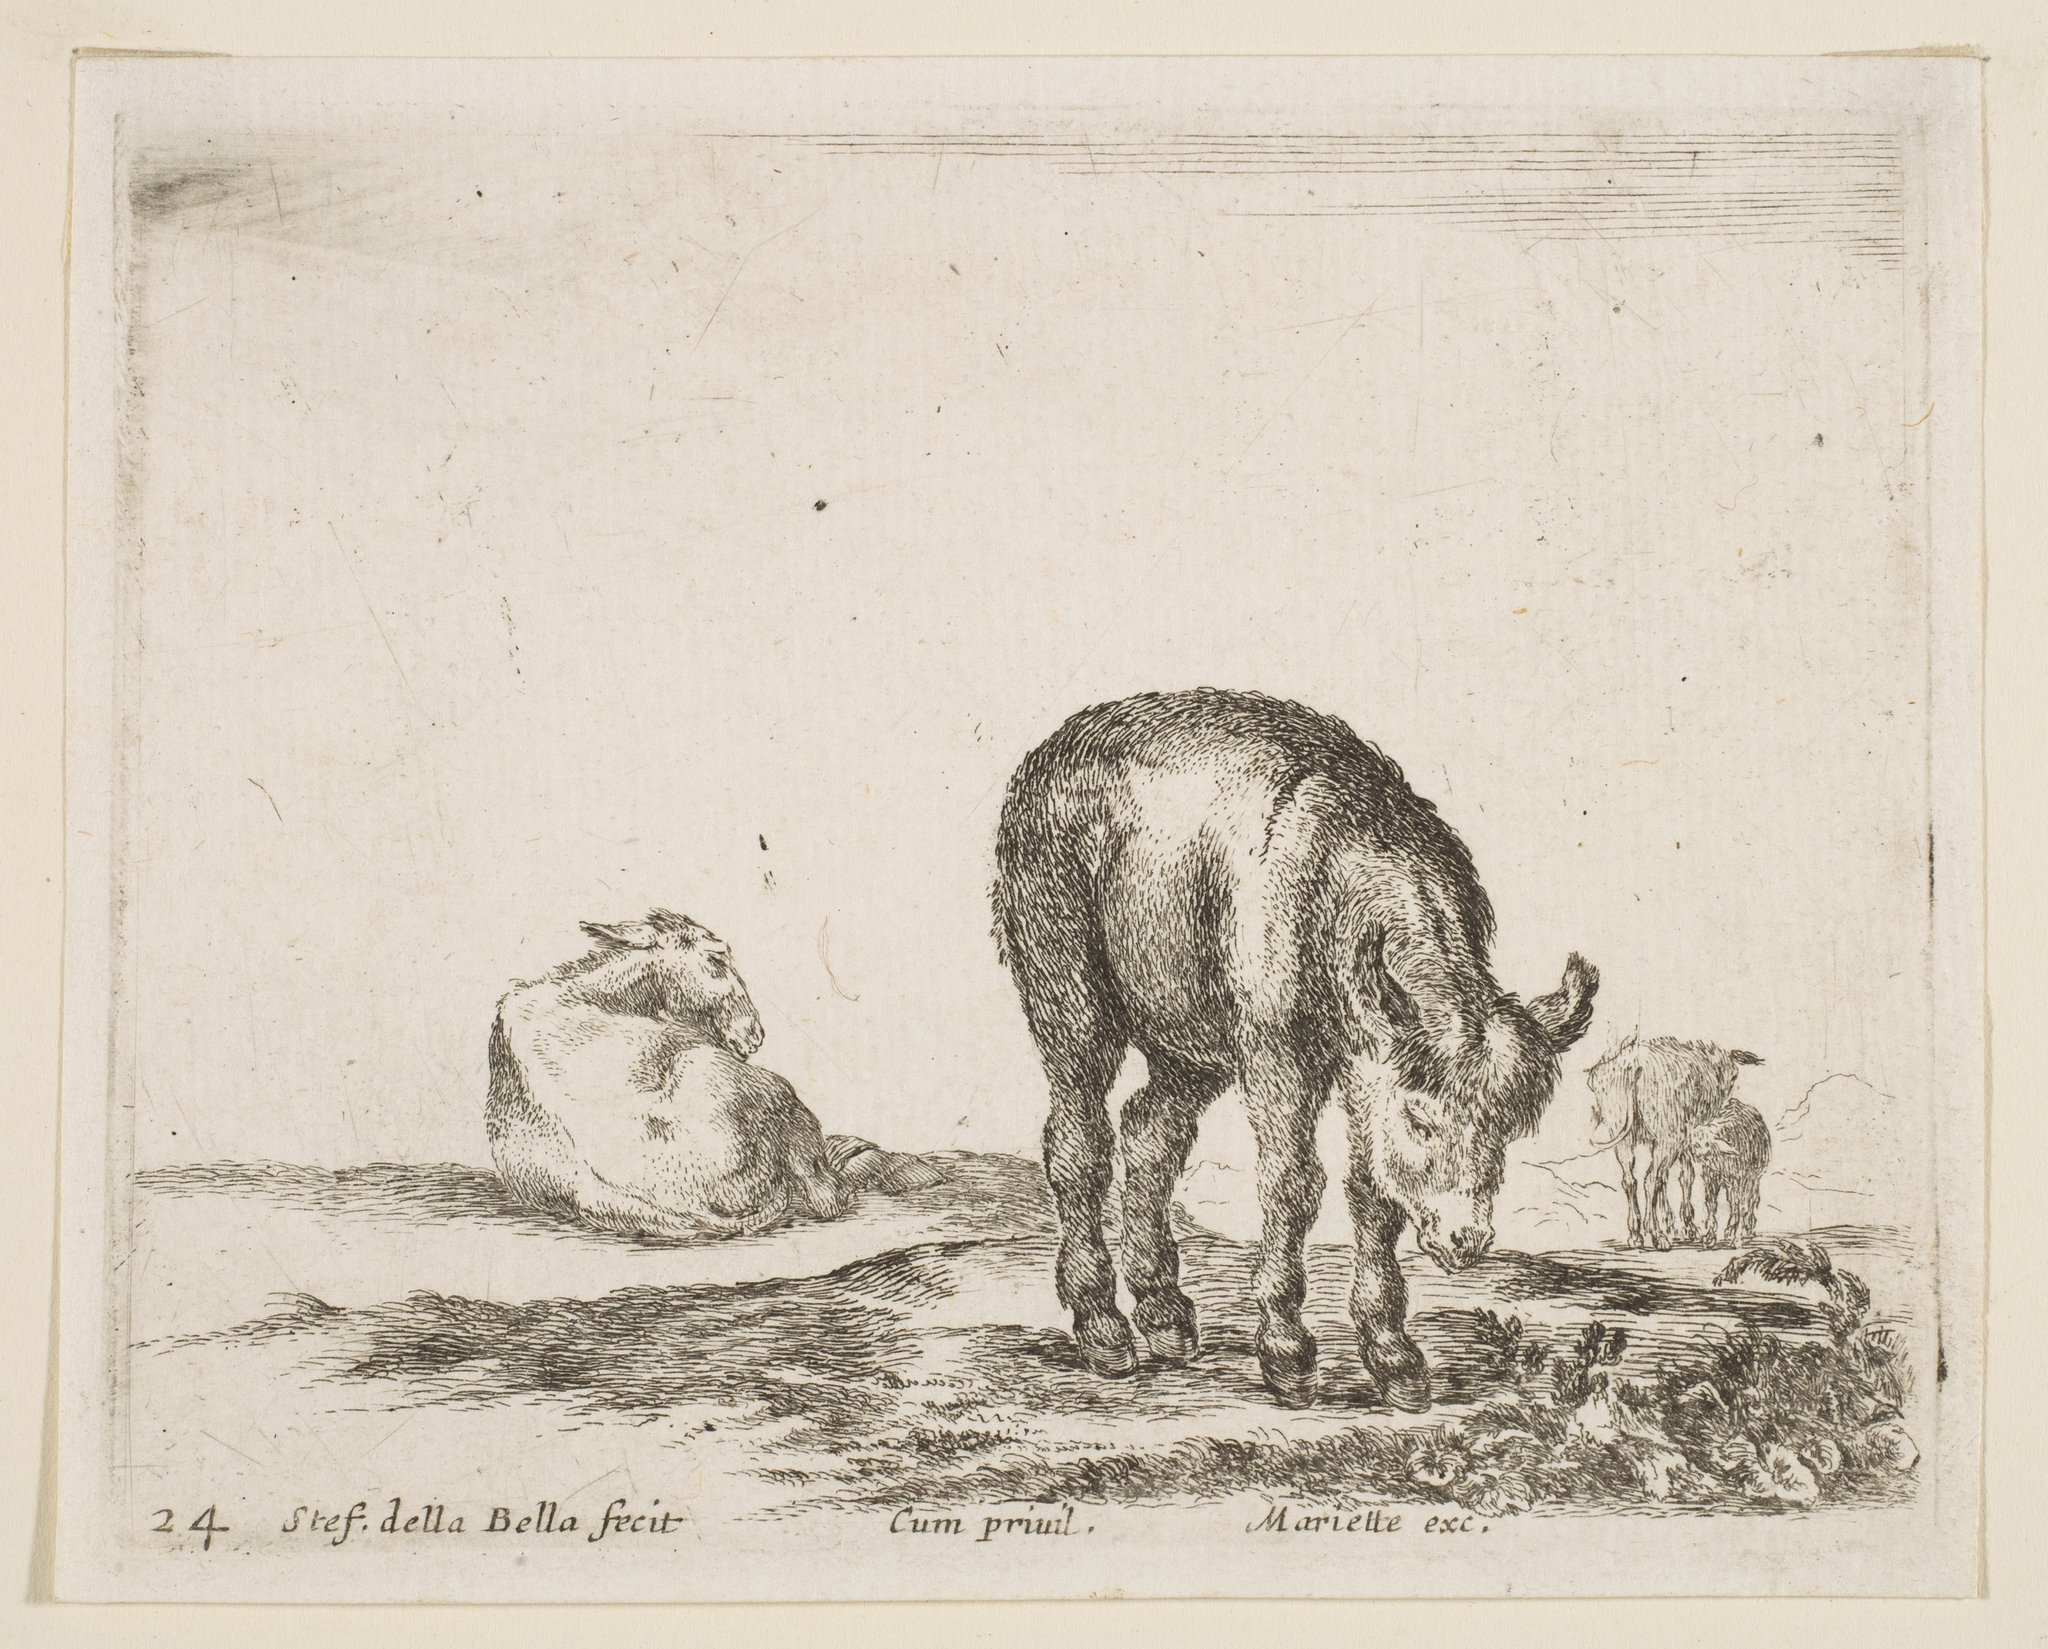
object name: print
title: Donkeys, plate 24 from "Various Animals" (Diversi Animali)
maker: stefano della bella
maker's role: artist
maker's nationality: italian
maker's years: 1610-1664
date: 1641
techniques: etching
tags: donkeys